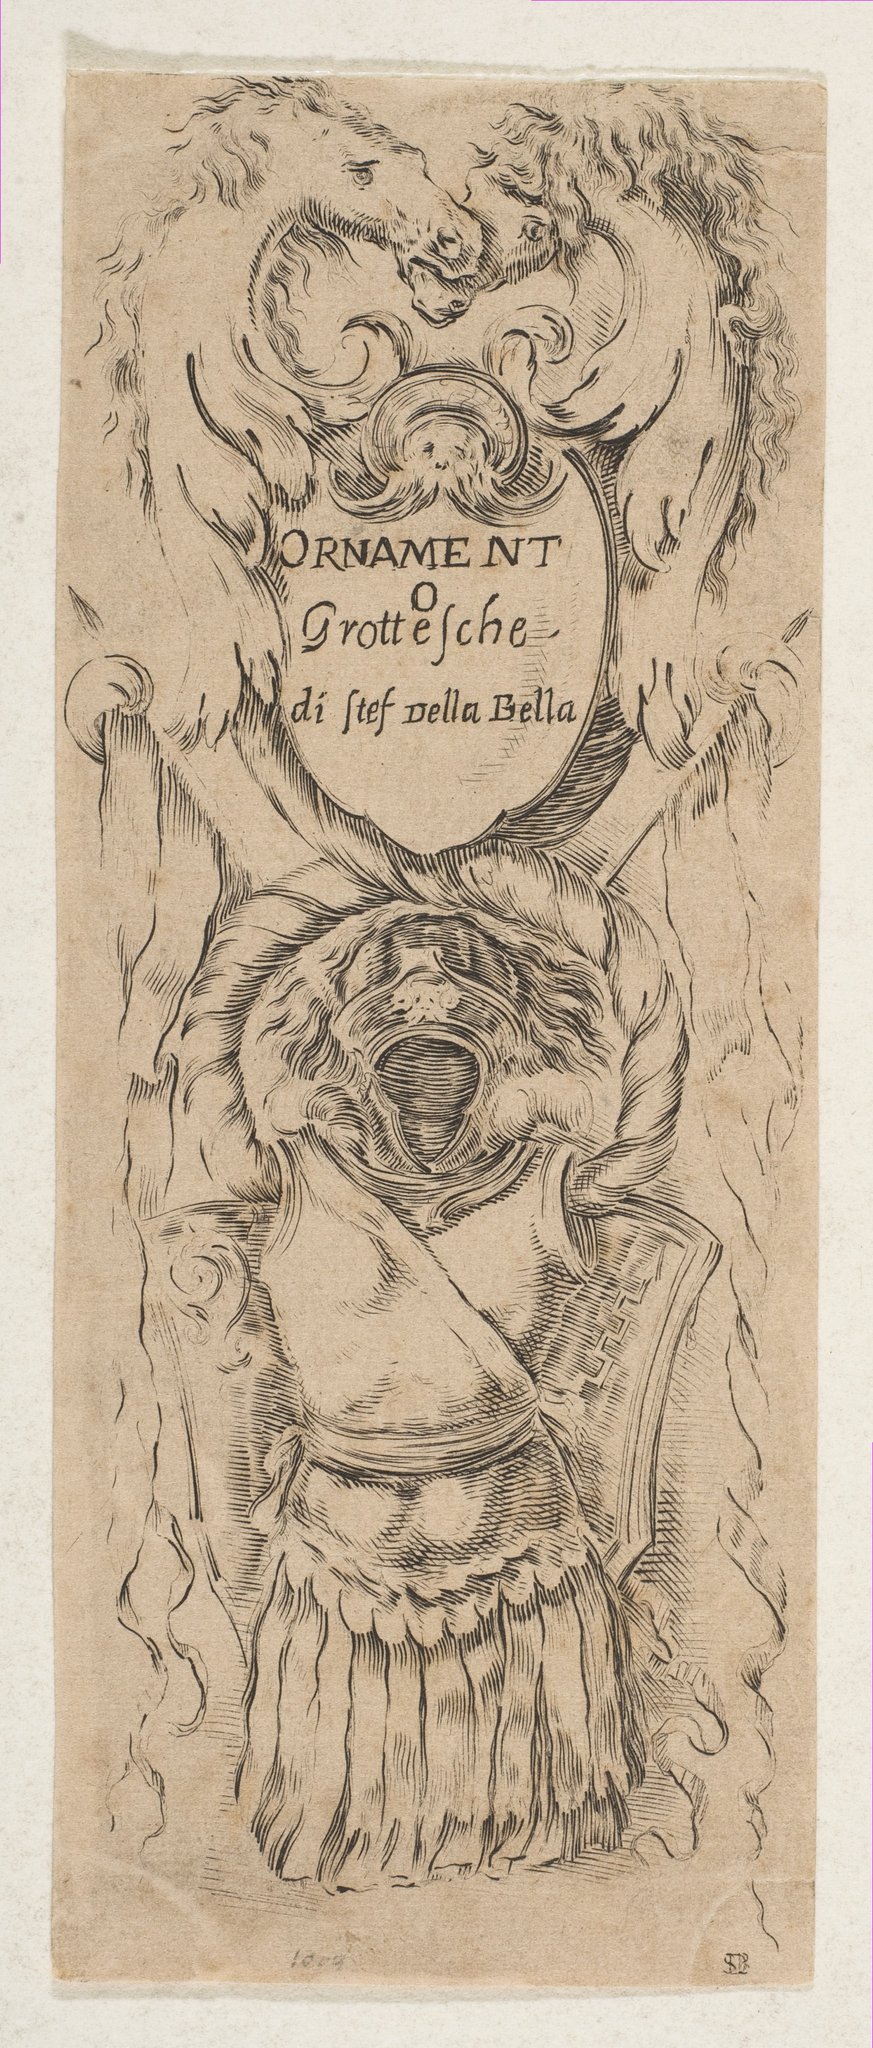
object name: print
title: Two Horse Heads Framing a Shield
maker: stefano della bella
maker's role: artist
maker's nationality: italian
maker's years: 1610-1664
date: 1653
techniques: etching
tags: armor,shields,horses